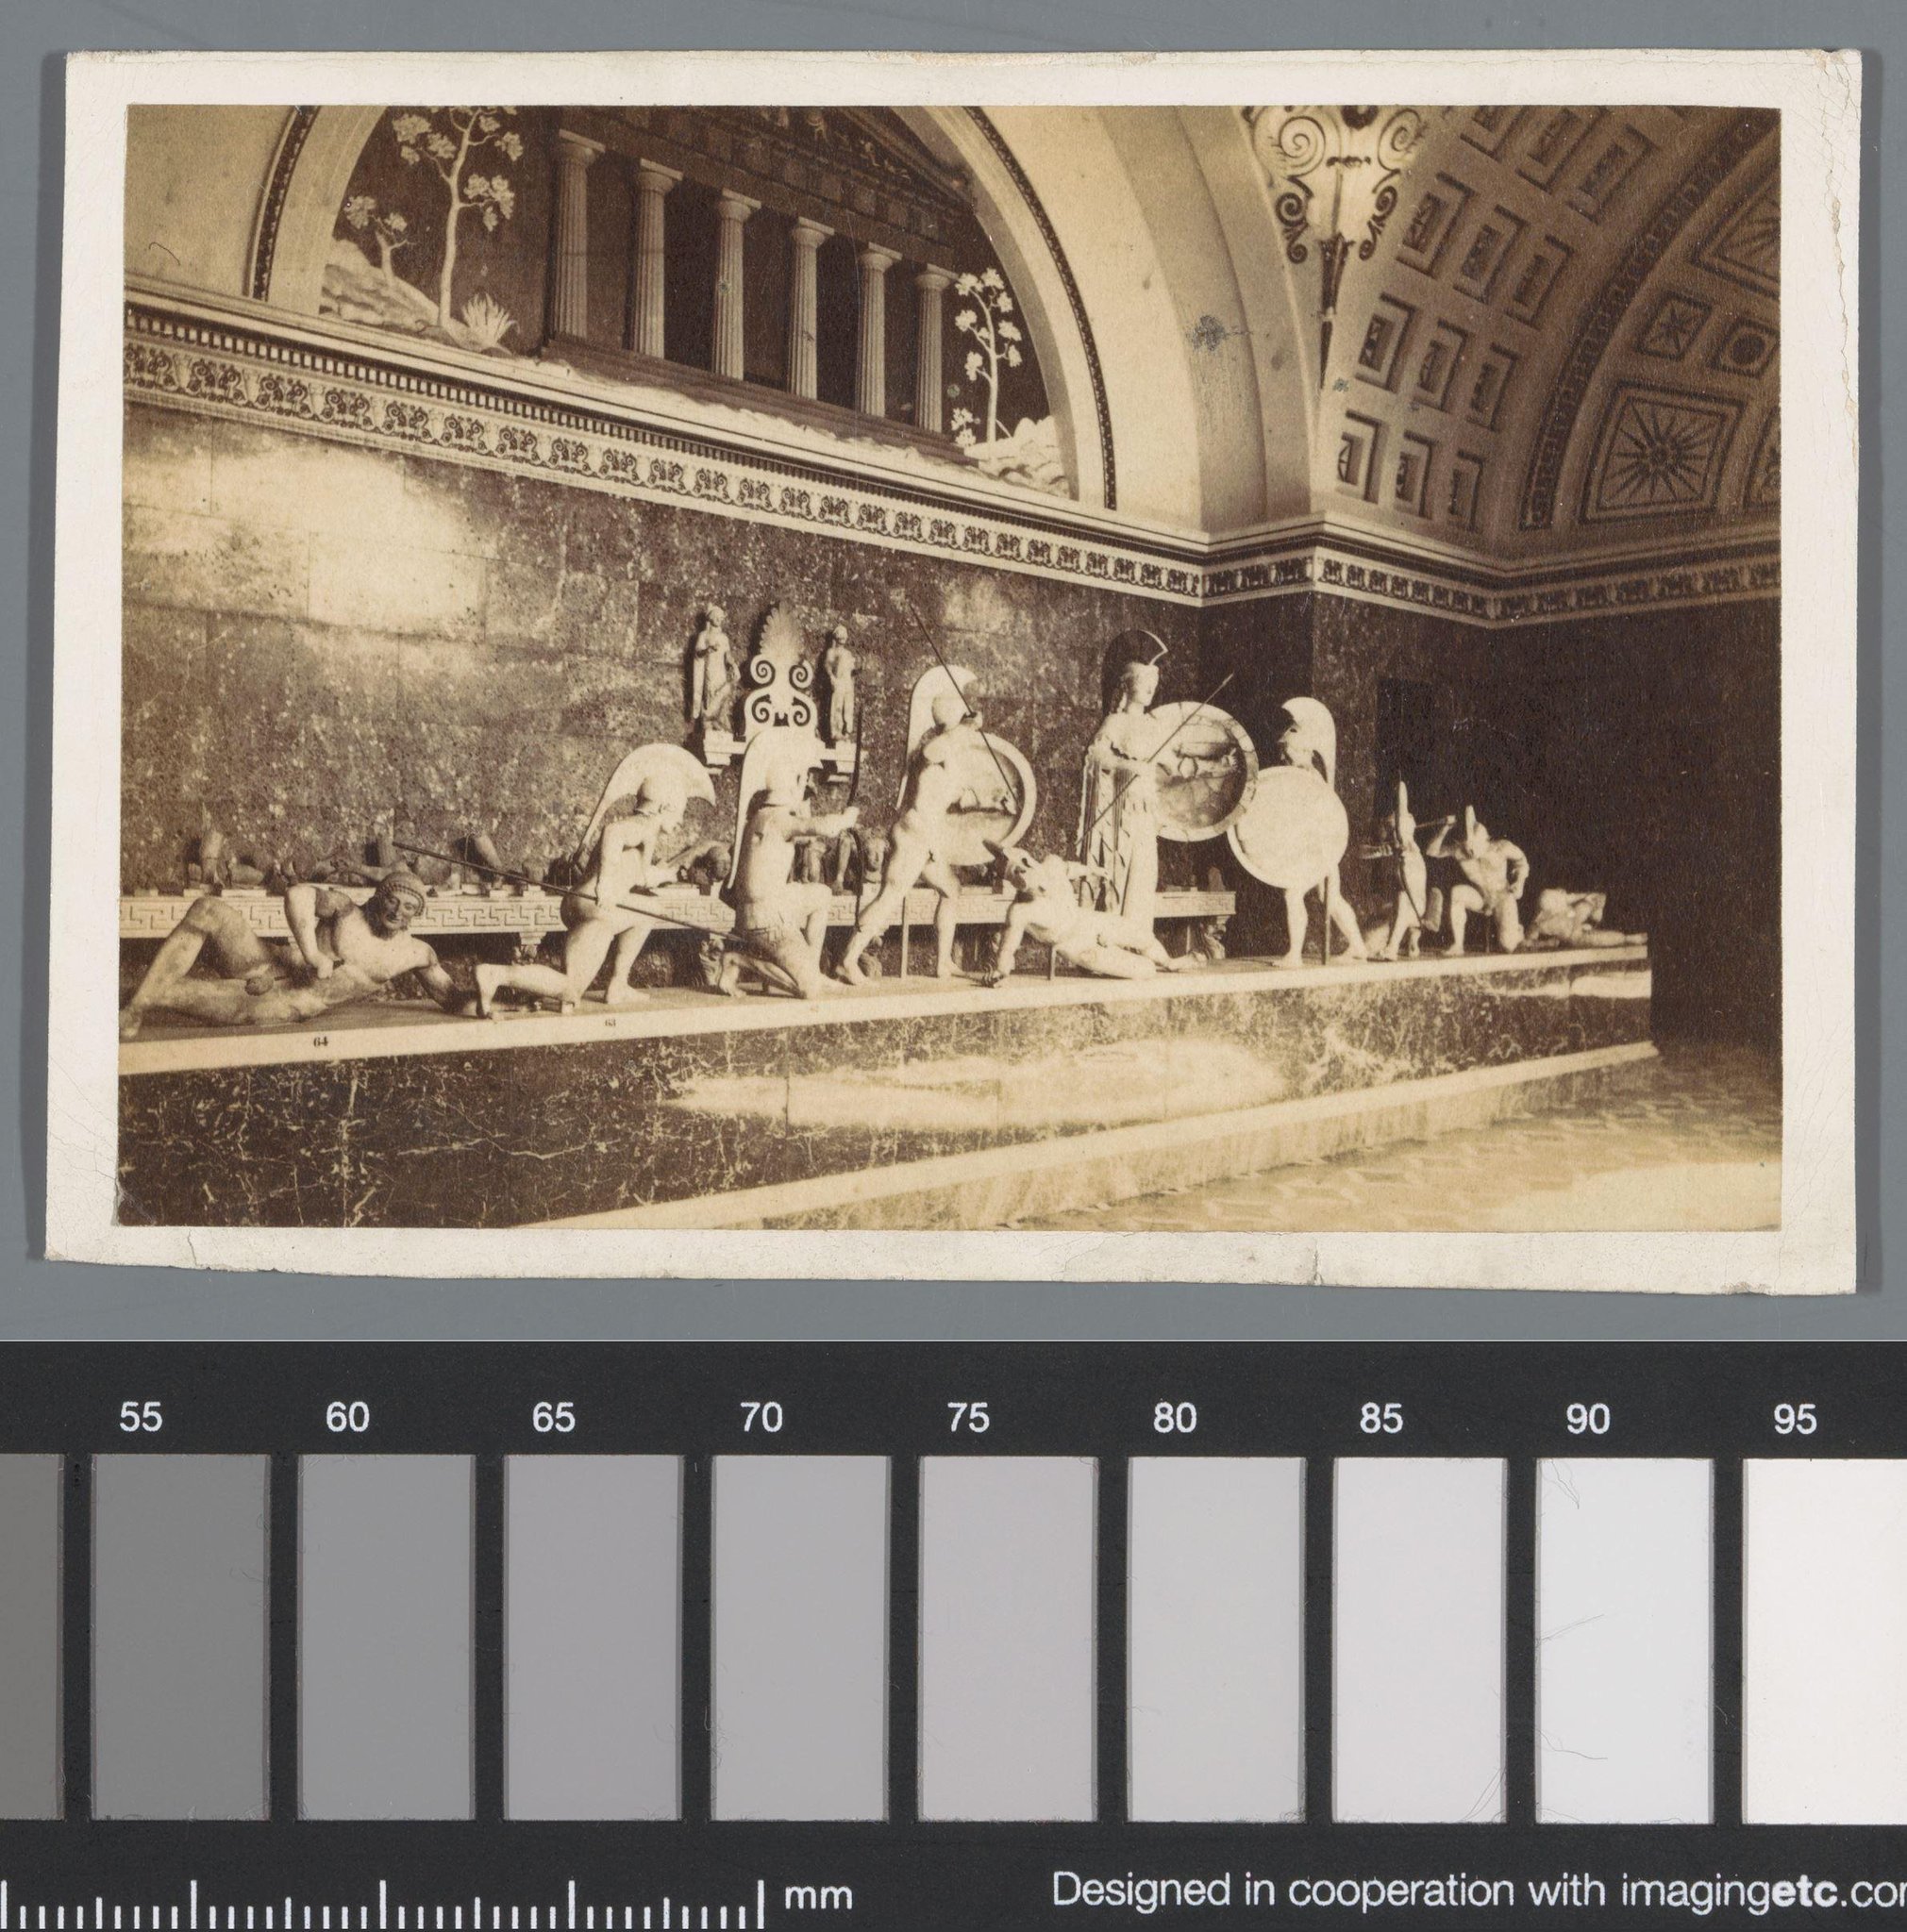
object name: photograph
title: Aeginetenzaal in de Glyptothek in München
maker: ernst reulbach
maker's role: fotograaf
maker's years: 1823-1874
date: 1855-1885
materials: cardboard, paper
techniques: albumen print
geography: munich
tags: permanent exhibition, museum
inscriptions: inscription: ‘Laut Leipziger Eintragsrolle gegen Nachdruck geschützt./ Der Aegineten-Saal./ Dieser Saal enthält nur Gegenstände aus den Tempel-/ Ruinen des Zeus Panellenios auf der Insel Aegina. Die/ Ornamente sind im griechischen Style gehalten, unter/ denen, dem Fenster gegenüber, die Vorderseite des/ Tempels selbst als Basreleif angebracht ist./ Photographie von E. Reulbach in Müchen./ Laut Leipziger Eintragsrolle gegen Nachdruck geschützt.’